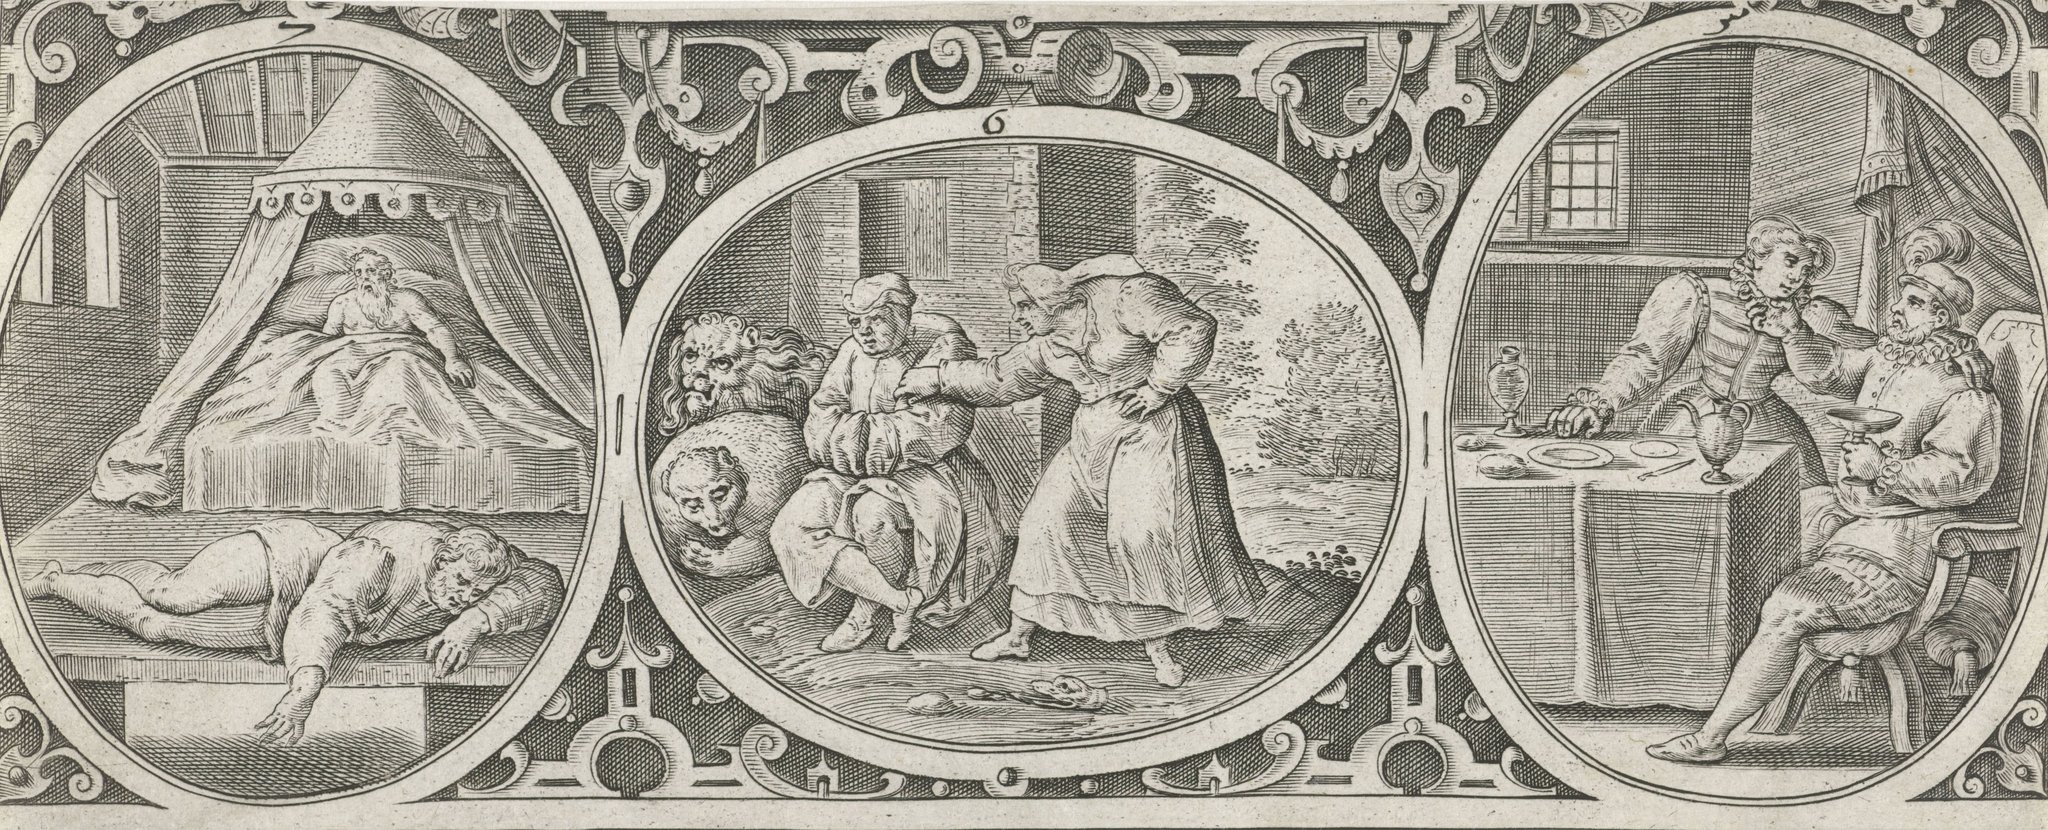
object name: print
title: Gnomae seu sententiae vitae utiles ex ecclesiastico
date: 1547-1591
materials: paper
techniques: engraving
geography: antwerp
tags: the book of ecclesiasticus, the wisdom of jesus sirach (with book chapter:verse)